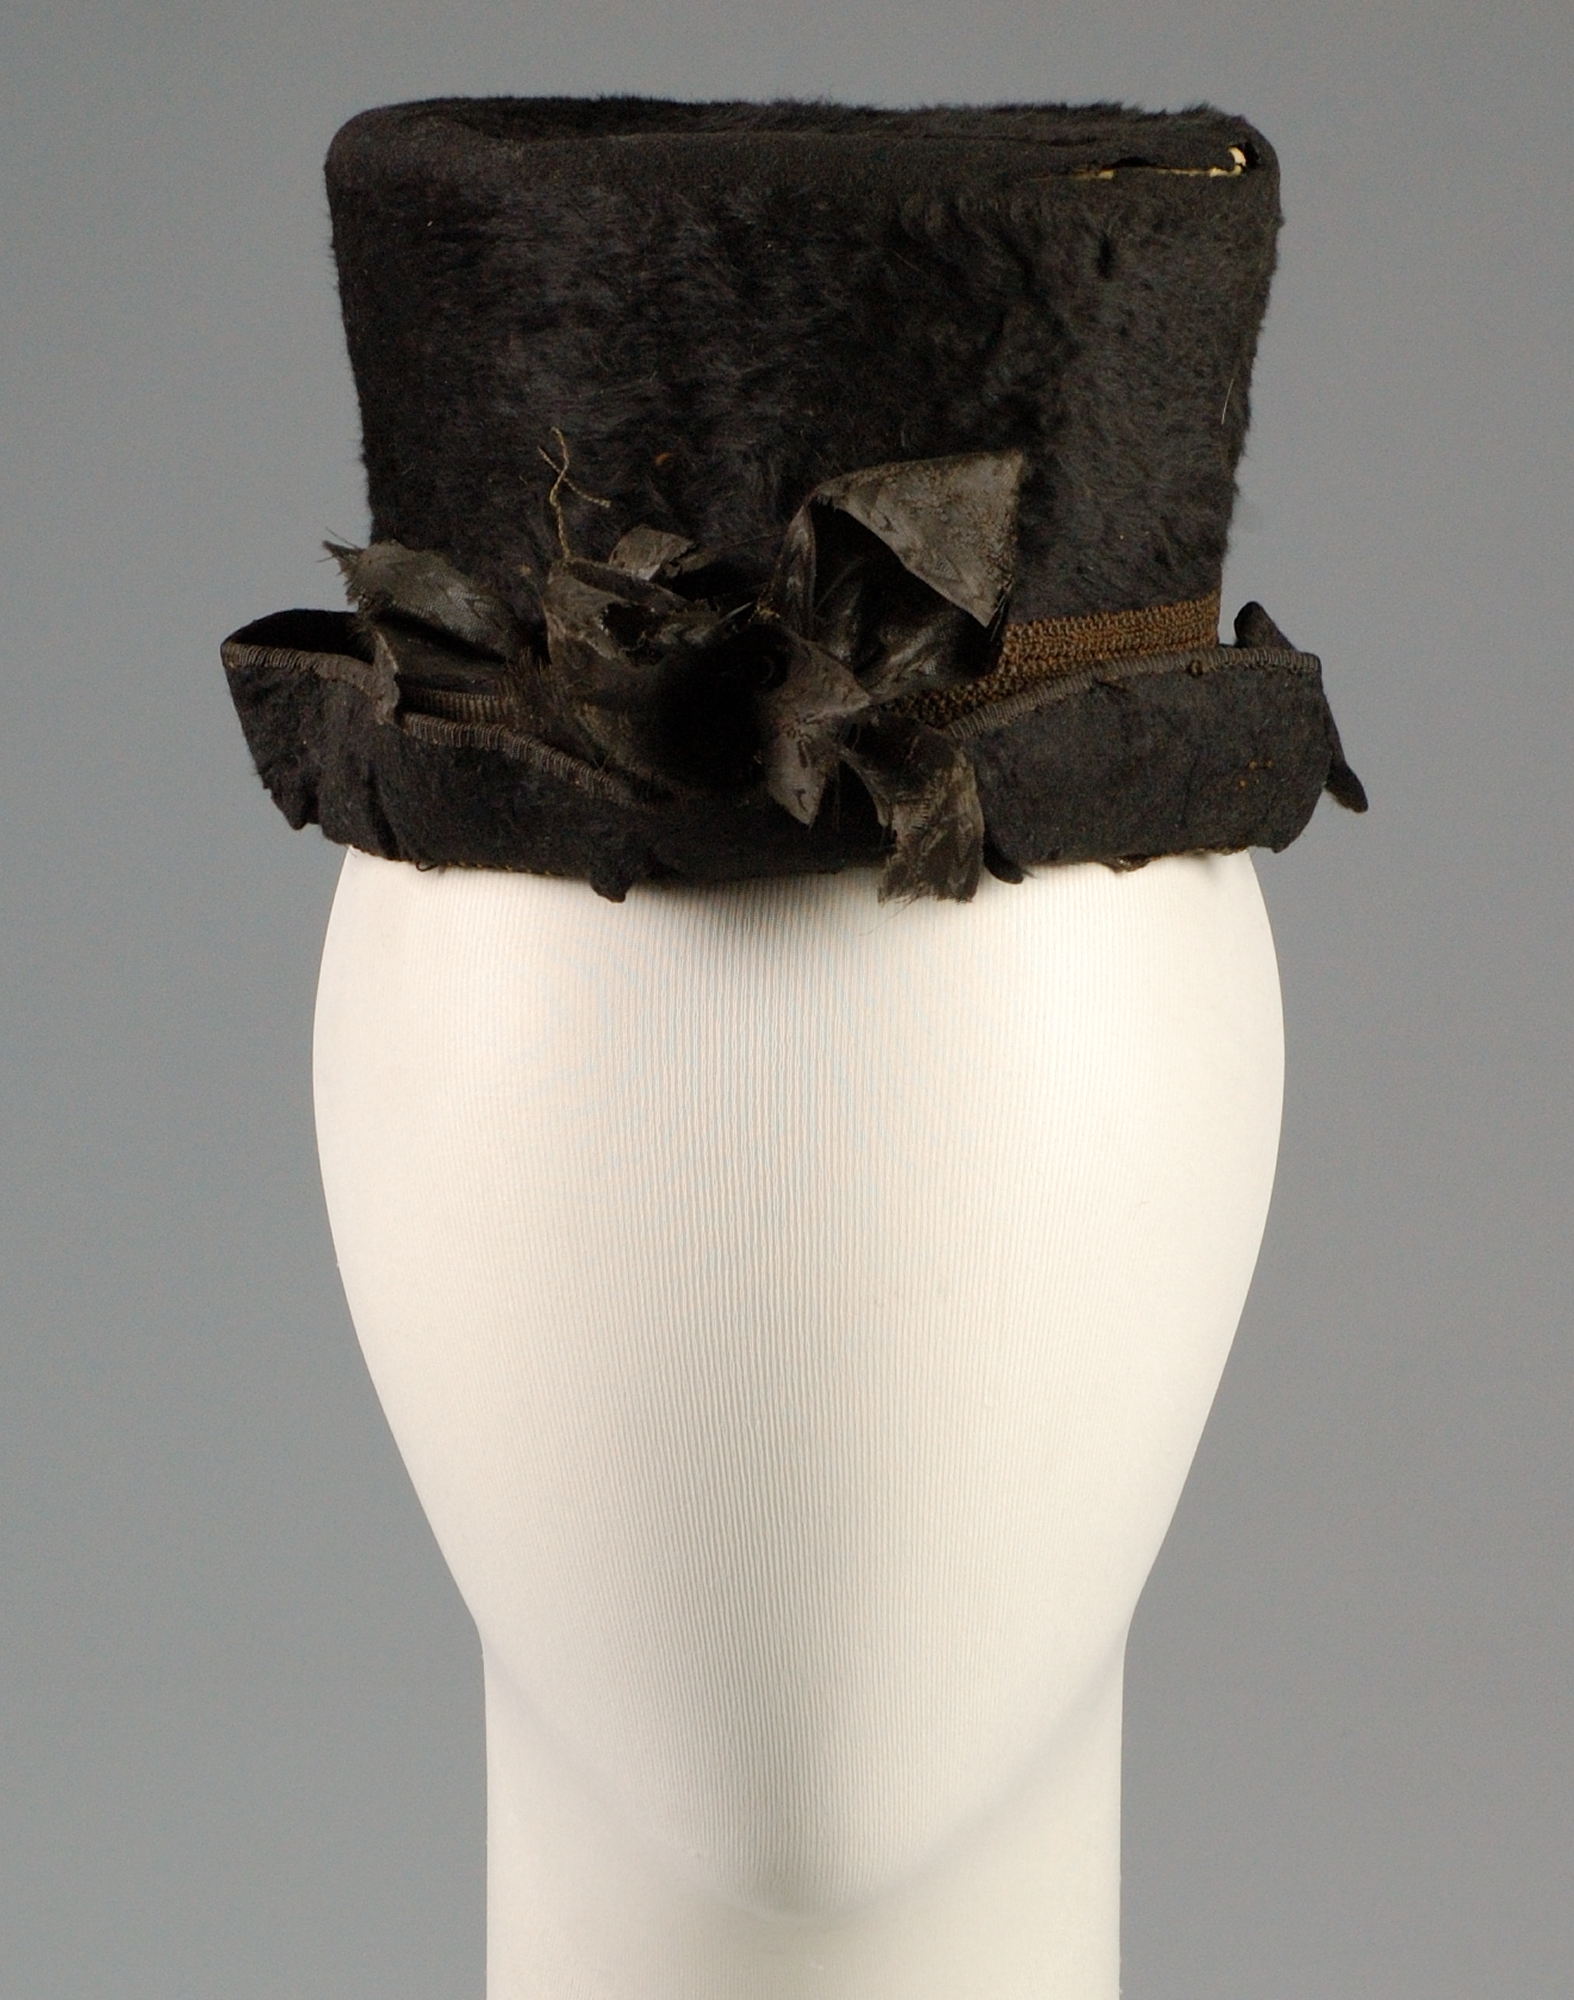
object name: hat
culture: british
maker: r. townsend & sons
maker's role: maker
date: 1790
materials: fur, silk